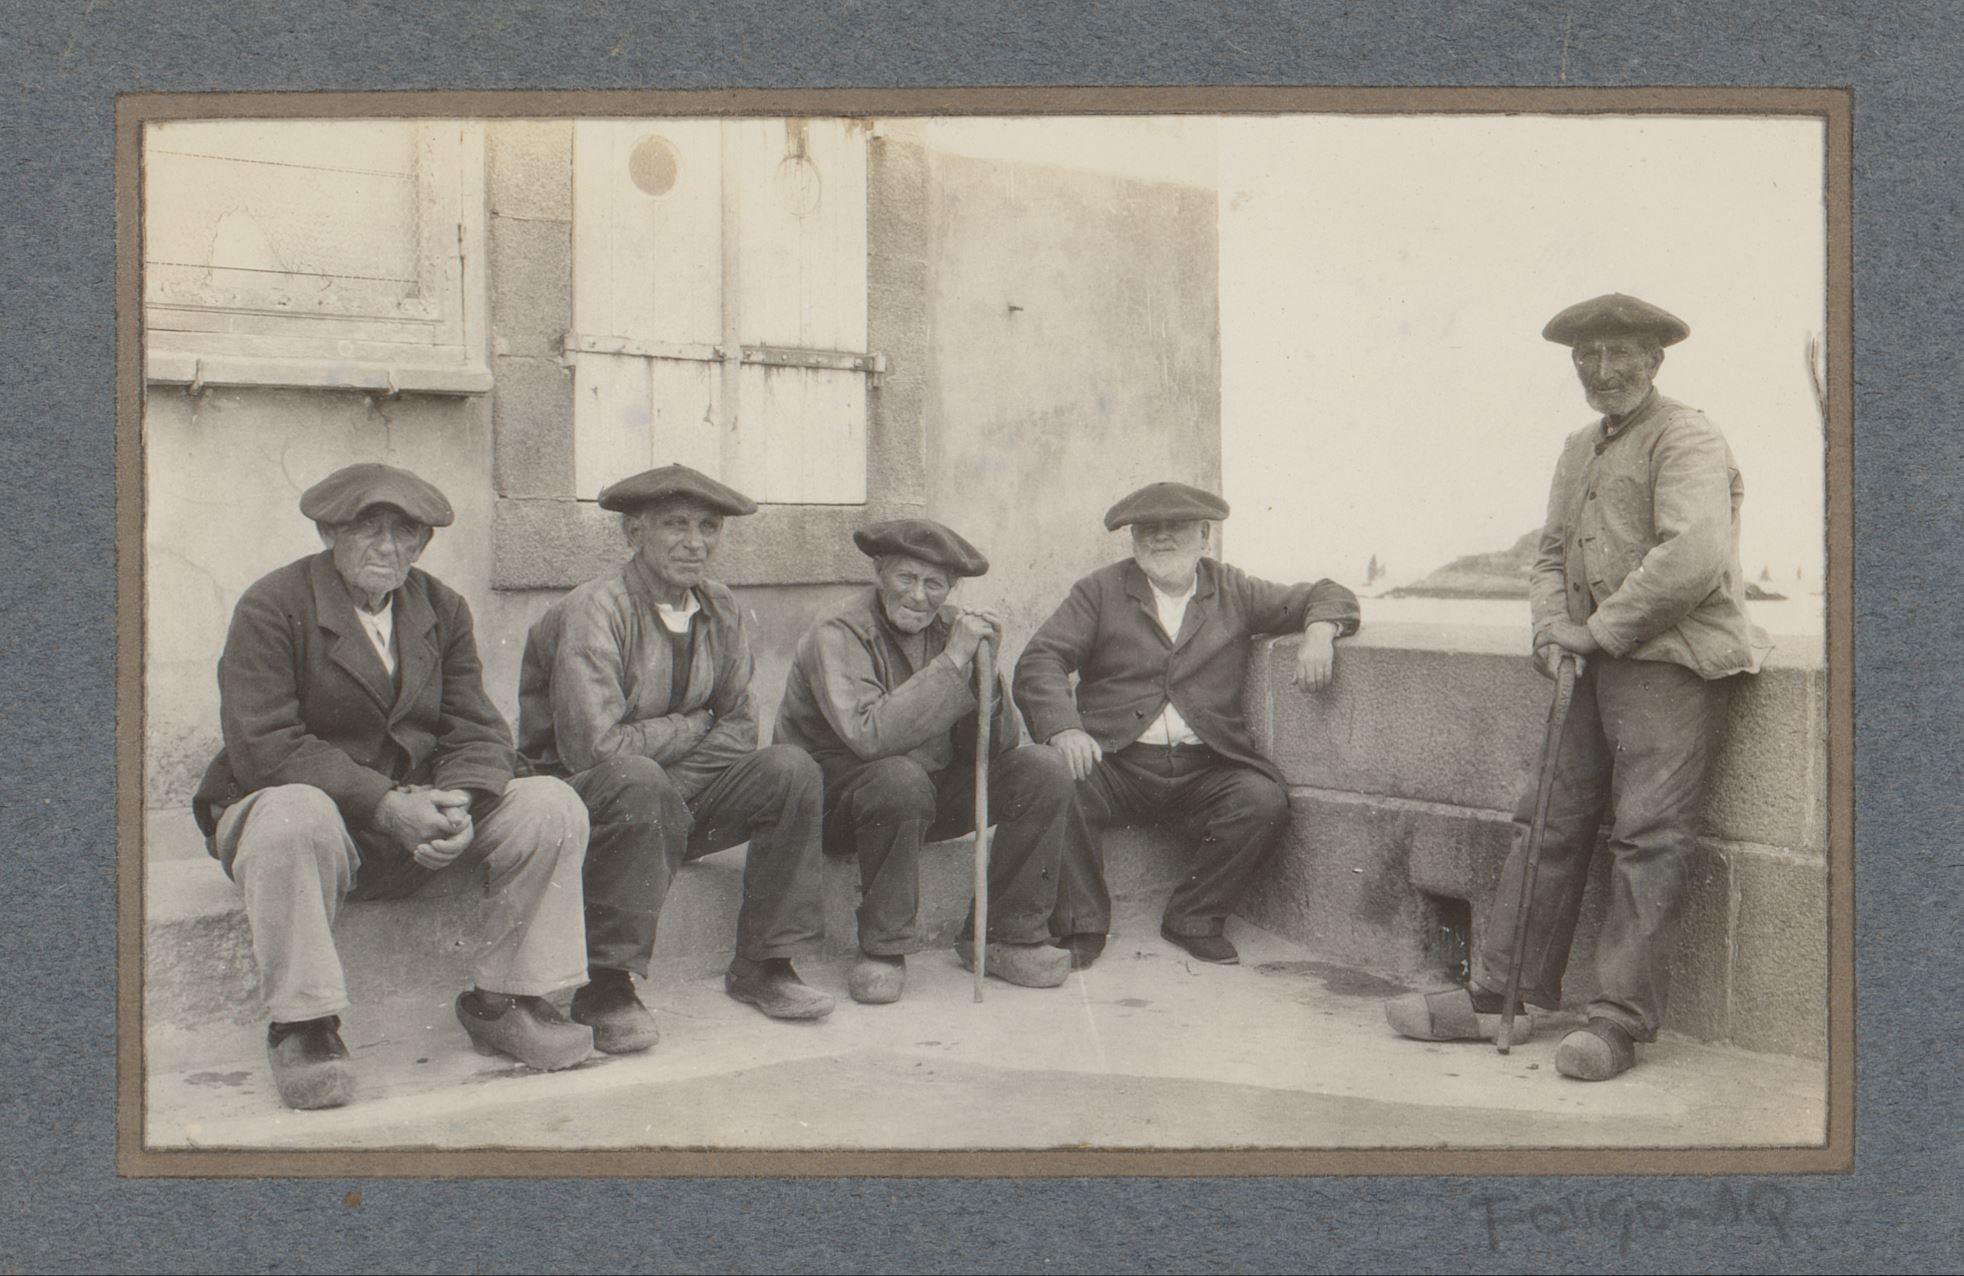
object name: album leaf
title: Vijf oude mannen met petten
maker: Anonymous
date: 1914-1927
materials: photographic support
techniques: gelatin silver print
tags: old man, head-gear: hat, anonymous historical persons portrayed in a group, in a group-portrait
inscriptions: inscription: ‘Opnamen gemaakt met de Autografische "Kodak"No. 3a./ Afdrukken gemaakt op "Velox" papier.’